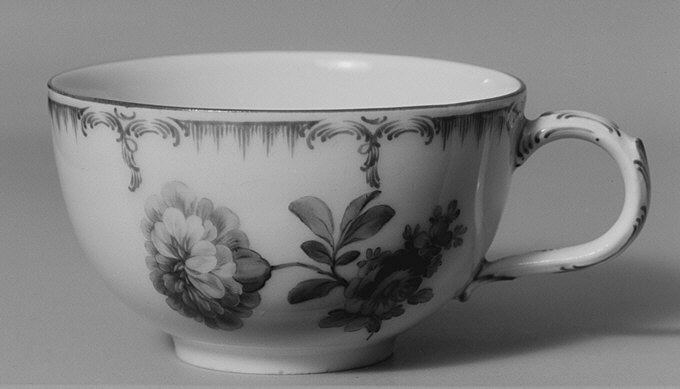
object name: cup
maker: royal porcelain manufactory, berlin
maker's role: manufactory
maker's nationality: german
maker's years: 1763-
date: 1770-1775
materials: hard paste porcelain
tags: flowers